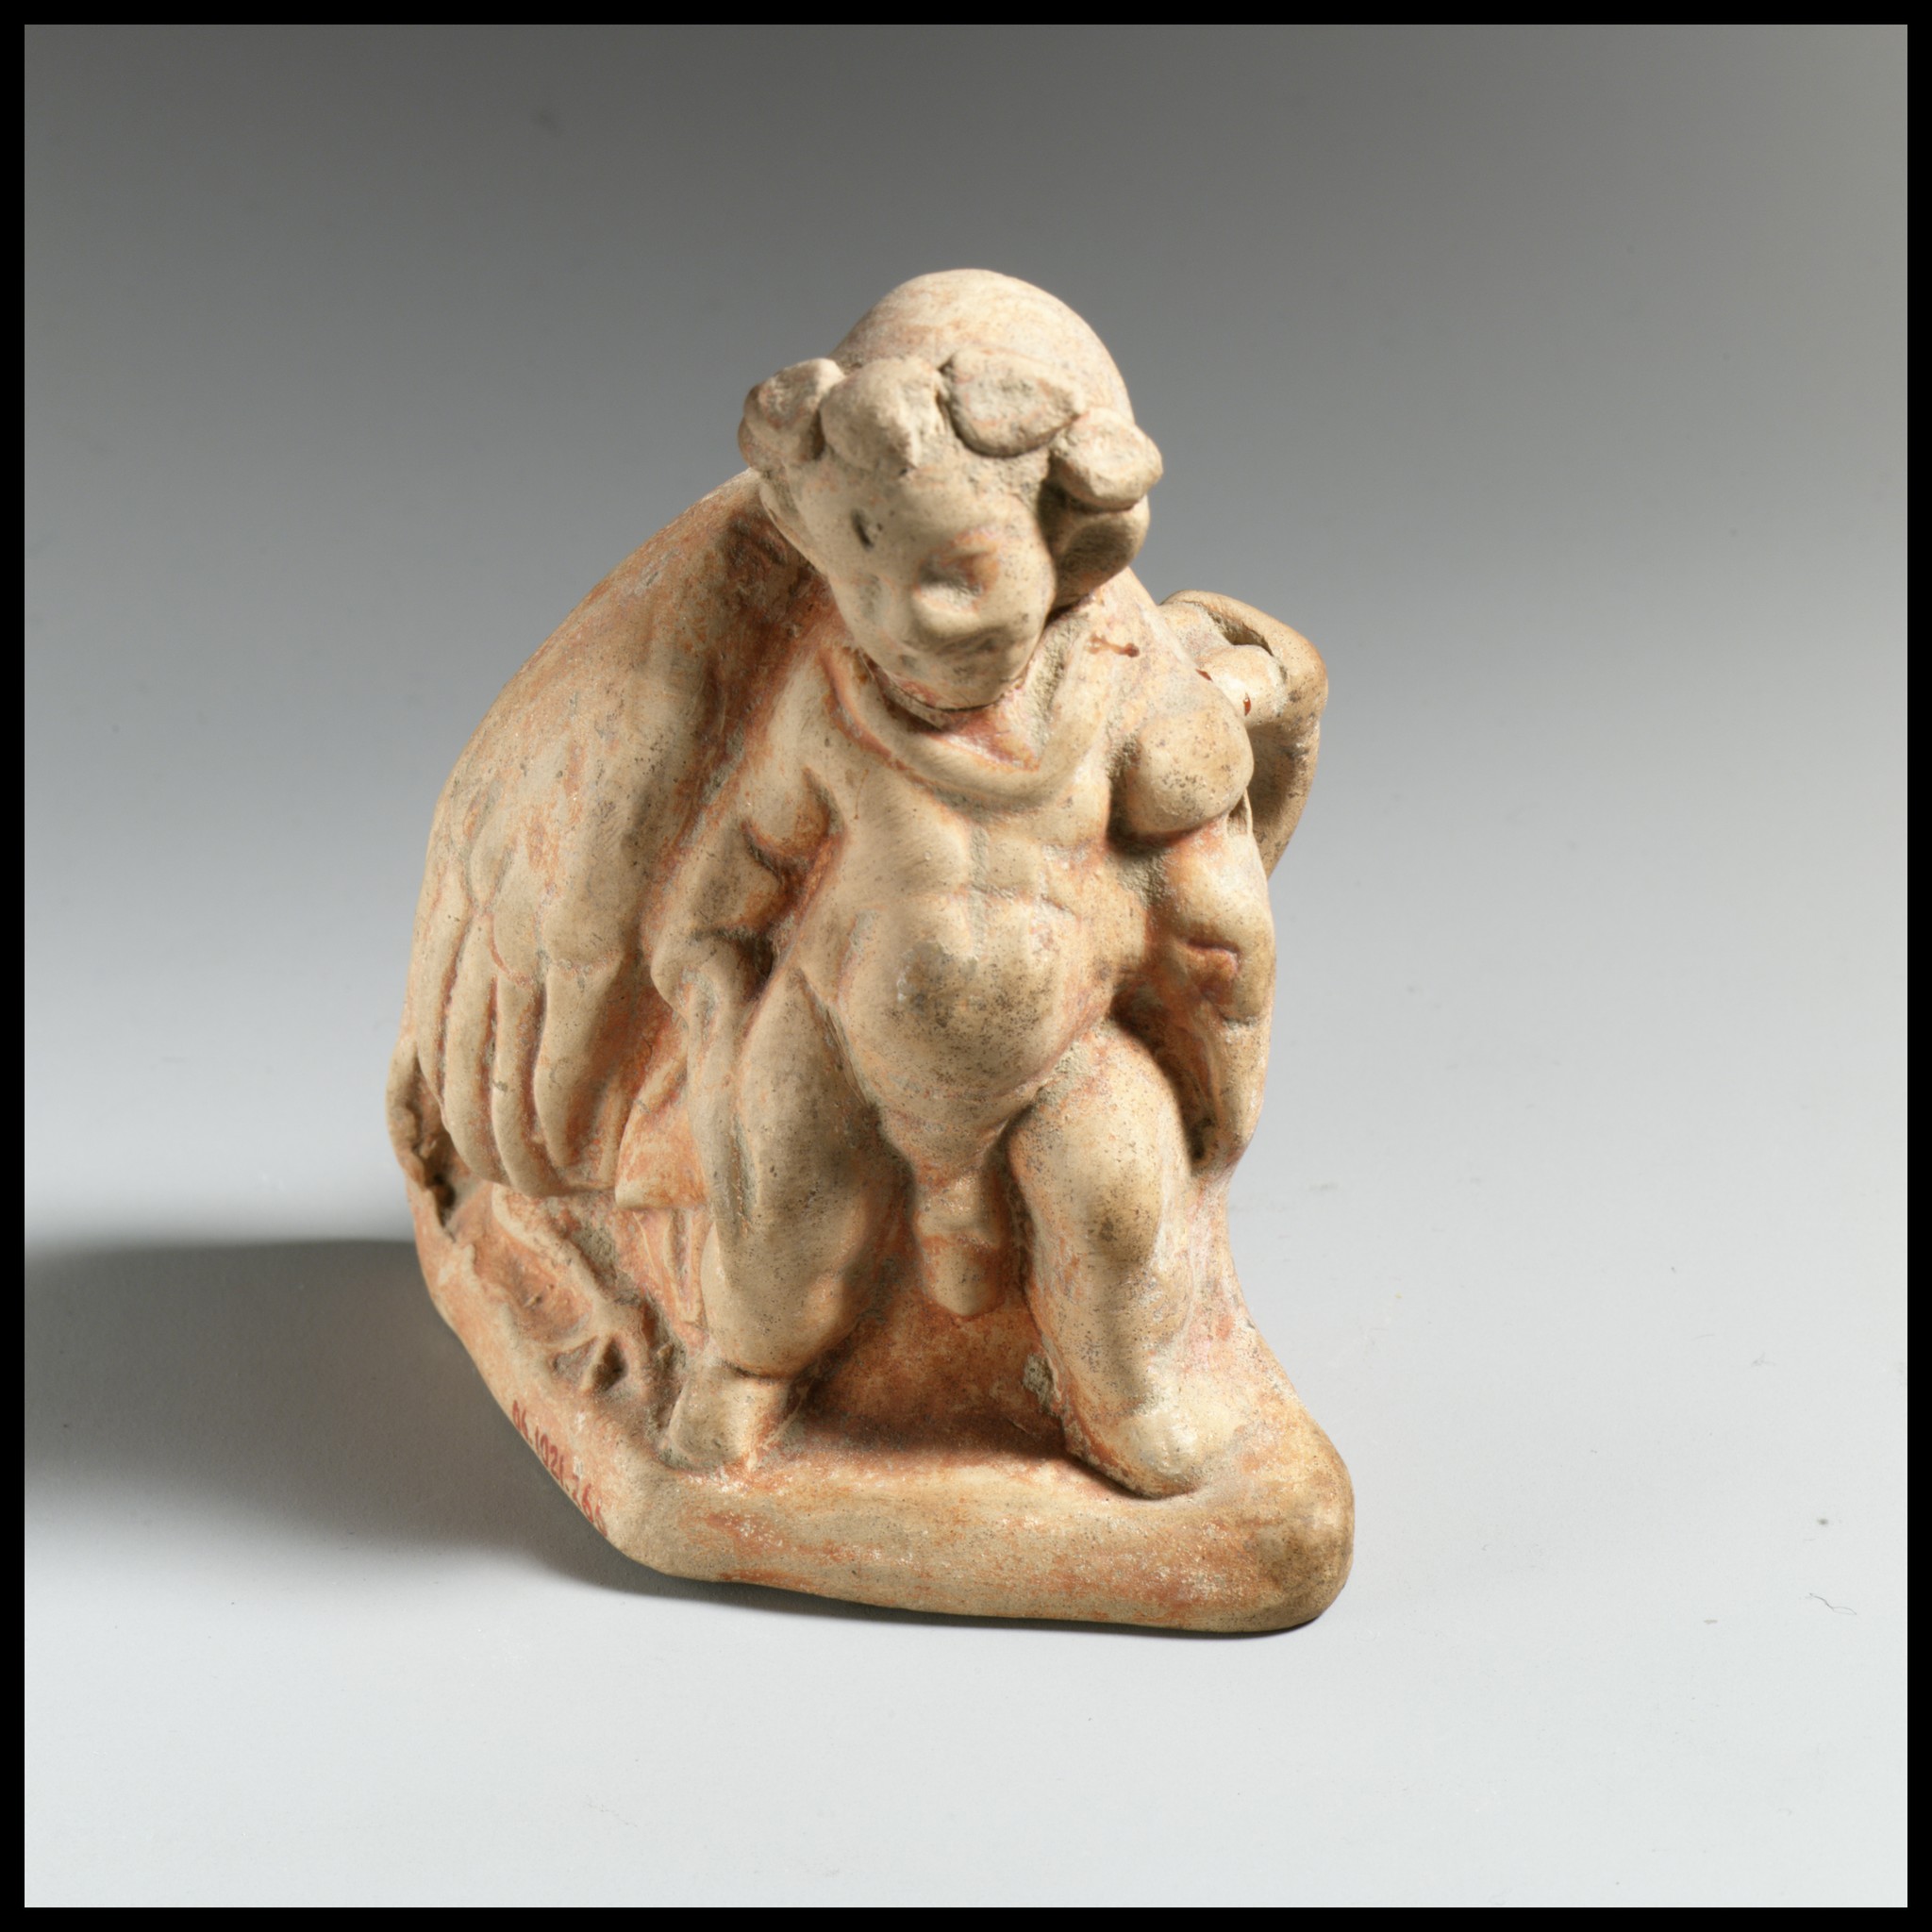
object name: vase in the form of a pygmy carrying a dead crane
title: Terracotta vase in the form of a pygmy carrying a dead crane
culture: greek or south italian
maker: magenta class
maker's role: artist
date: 300-201 BCE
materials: terracotta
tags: human figures,cranes